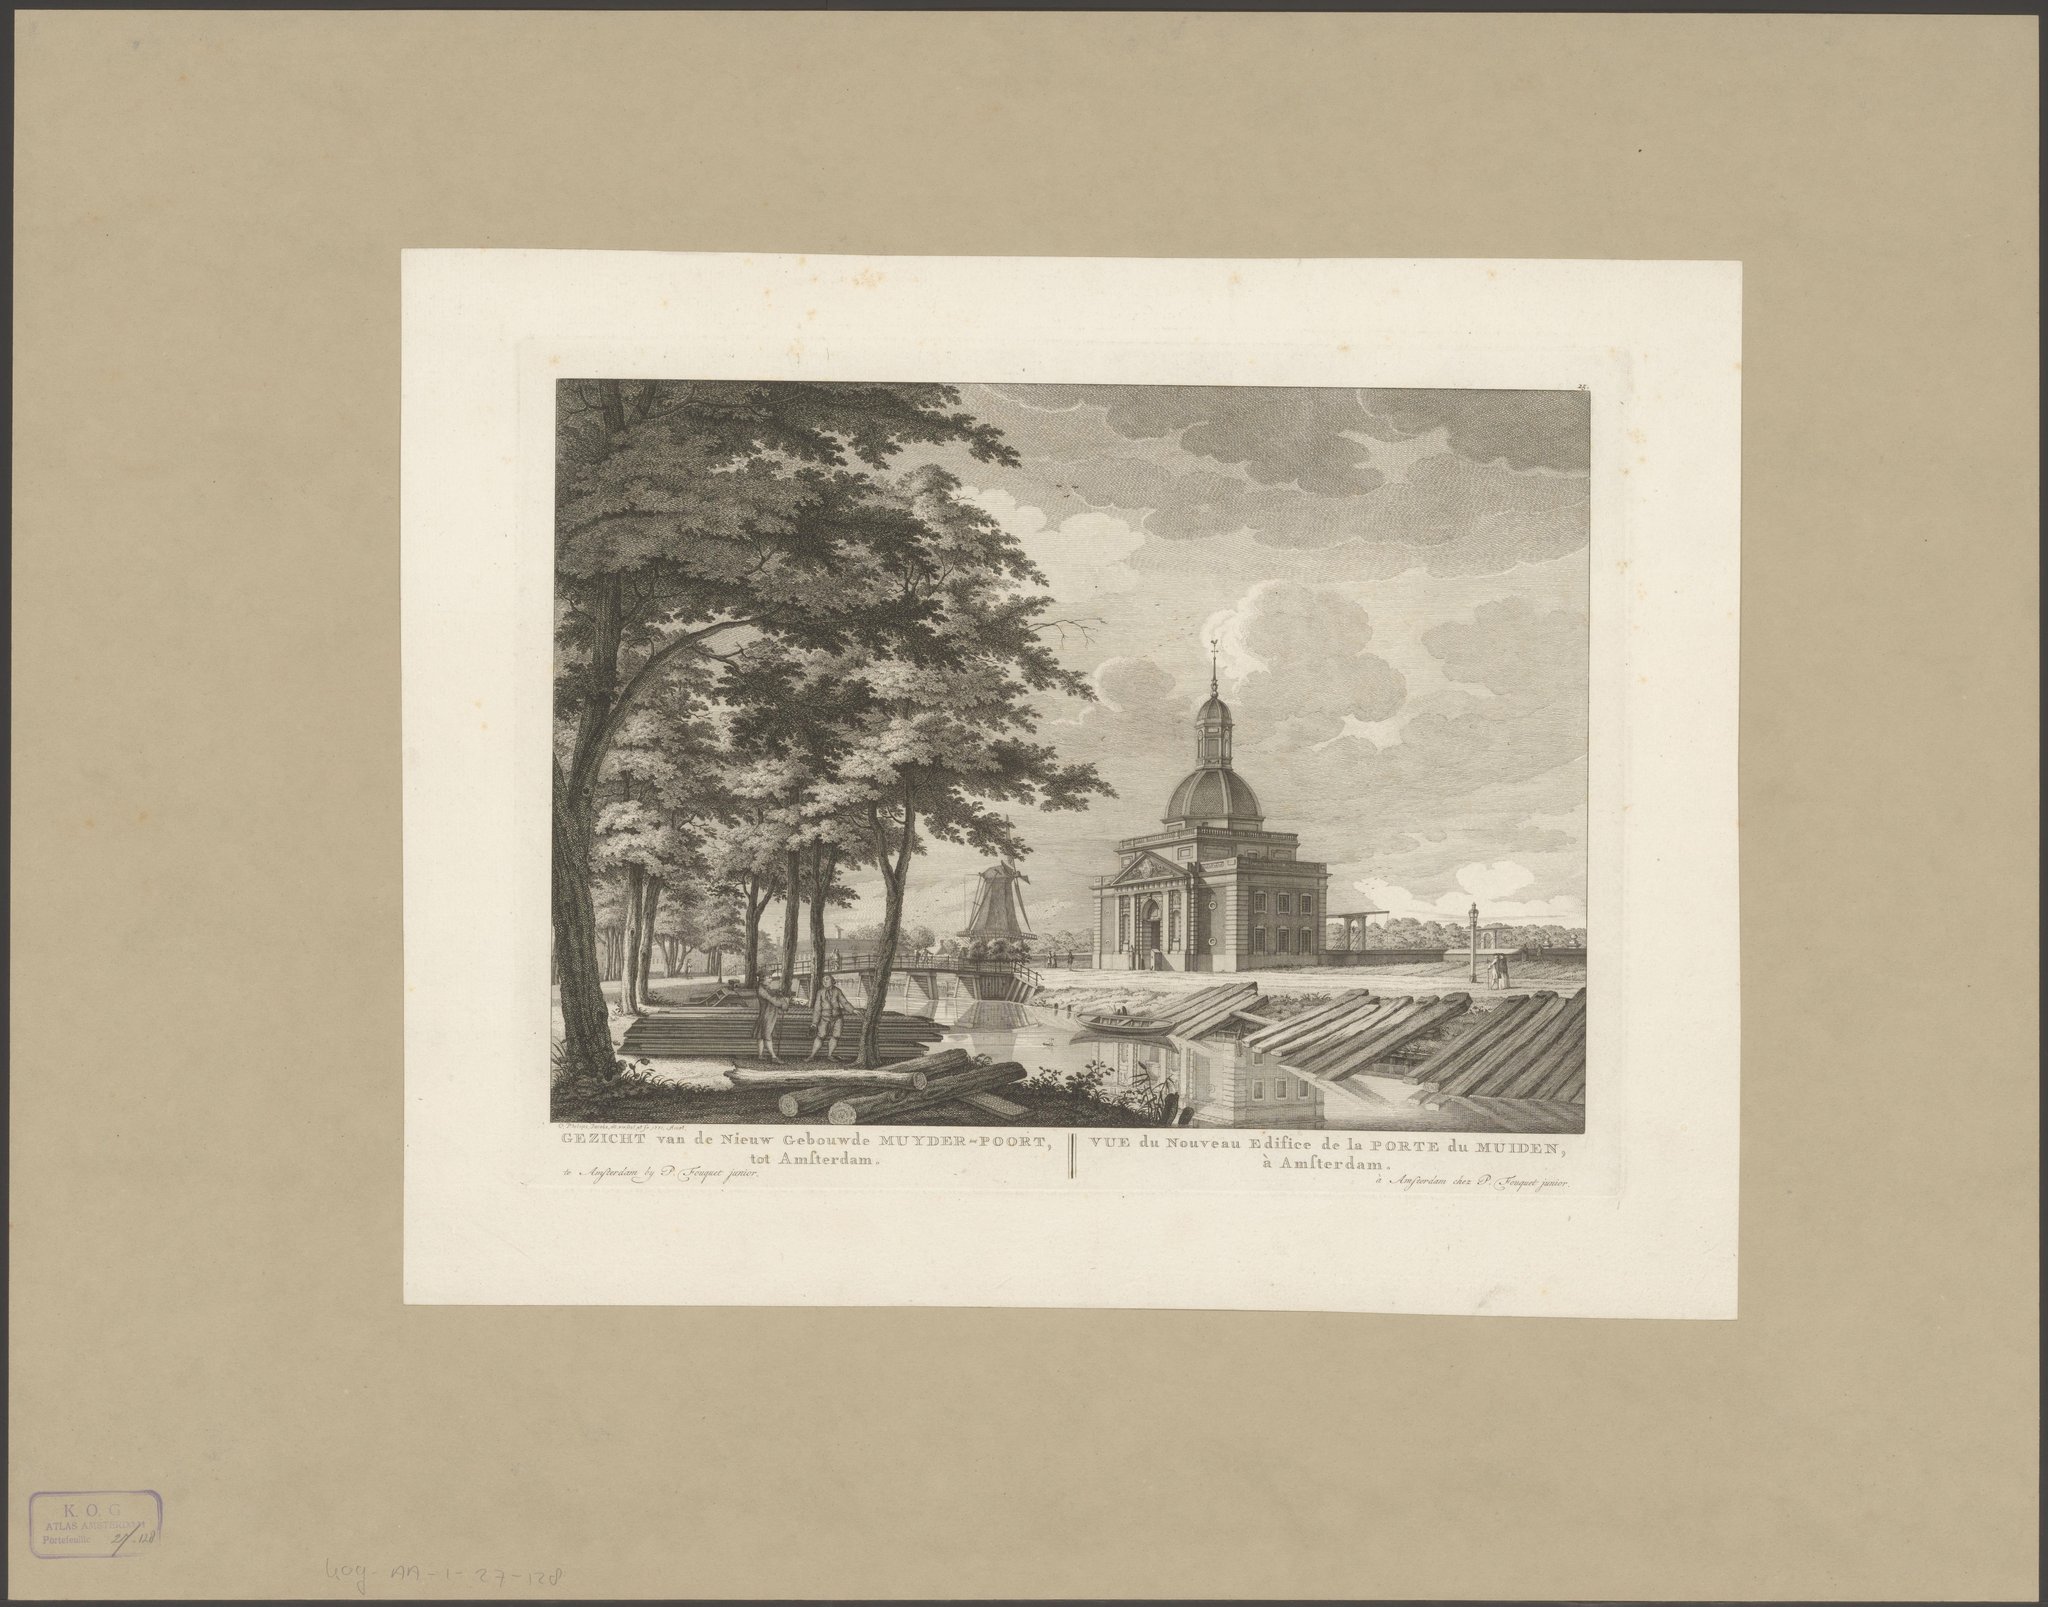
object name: print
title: Gezicht van de Nieuw Gebouwde Muyder-Poort, tot Amsterdam / Vue du Nouveau Edifice de la Porte du Muiden, à Amsterdam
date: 1771-1783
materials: paper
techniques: engraving, etching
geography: amsterdam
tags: bridge in city across river, canal, etc. (+ city(-scape) with figures, staffage), canals, waters (in city), city-gate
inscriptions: collector's mark: Lugt 1641b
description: Deze prent is ook gebruikt in de zogenaamde Atlas van Fouquet.* Pierre Fouquet gaf vanaf 1760 stadsgezichten van Amsterdam - naar tekeningen van verschillende kunstenaars, gemaakt door verschillende prentmakers - uit. Deze prenten werden aanvankelijk los of in series verkocht. Zoals toen gebruikelijk kon de koper de prenten zelf laten inbinden. Hiertoe gaf Fouquet tussen 1778 en 1783 een titelblad, plattegrond en inhoudsopgave van de tot dusver 100 uitgegeven prenten uit (1). Gezien de inhoud afhankelijk was van wat de koper had verzameld verschilt de inhoud van de verschillende bewaarde Fouquetatlassen onder deze titel sterk. Ook zijn er exemplaren bekend waar tevens andere prenten aan zijn toegevoegd. Omdat er behoefte bleek aan uitleg bij de platen werd in 1783 een nieuwe versie van de atlas uitgegeven, aangevuld met tekst en twee prenten. De aangegeven volgorde veranderde maar de platen van de al eerder uitgegeven prenten bleven ongewijzigd. Deze uitgave werd in opdracht van Fouquet gedrukt bij Daniël Jean Changuion en Petrus den Hengst (2). Een tiental platen werd bijgewerkt en verscheen, met nieuw impressum, in het vervolg van Wagenaars geschiedenis van Amsterdam, uitgeven door Petrus Conradi en Folkert van der Plaats (3). Een aantal jaar na het overlijden van Fouquet kwam Evert Maaskamp met een nieuwe uitgave van de atlas, met verbeterde tekst en toevoeging van twee prenten. Op alle platen verwijderde hij het oude en liet hij zijn eigen impressum zetten (4). De huidige staat van de prent komt voor in exemplaren van de onder (1) en (2) genoemde werken. * Onder de Atlas van Fouquet of Fouquetatlas verstaan we de hieronder vermelde publicaties (1), (2) en (4). (1). Afbeeldingen van de wyd-vermaarde koopstad Amsterdam benevens des zelvs voornaamste gebouwen en gezigten alle naar het leeven getekend / Receuil des edifices les plus considerables et des plus belles vues, de la fameuse ville d'Amsterdam, dessinées d'après nature. Amsterdam: Pierre Fouquet, 1778-1783. (2). Nieuwe atlas, van de voornaamste gebouwen en gezigten der stad Amsterdam, met derzelver beknopte beschryvingen. 2 dln. Amsterdam: Daniël Jean Changuion en Petrus den Hengst [in opdracht van Pierre Fouquet], 1783. (3). Stijl, Simon. Amsterdam, in zyne geschiedenissen, voorregten, koophandel, gebouwen, kerkenstaat, schoolen, schutterye, gilden en regeeringe, beschreeven. Om te dienen ten vervolge op het werk van Jan Wagenaar (…). 10 dln. Amsterdam en Harlingen: Petrus Conradi en Folkert van der Plaats, 1788-1801. (4). Nieuwe atlas, van de voornaamste gebouwen en gezigten der stad Amsterdam. Met derzelver beknopte beschryvingen. Amsterdam: Evert Maaskamp, 1805. * Het aantal vermelde staten is gebaseerd op het aantal gevonden staten. Mogelijk zijn er meer staten van deze prent.